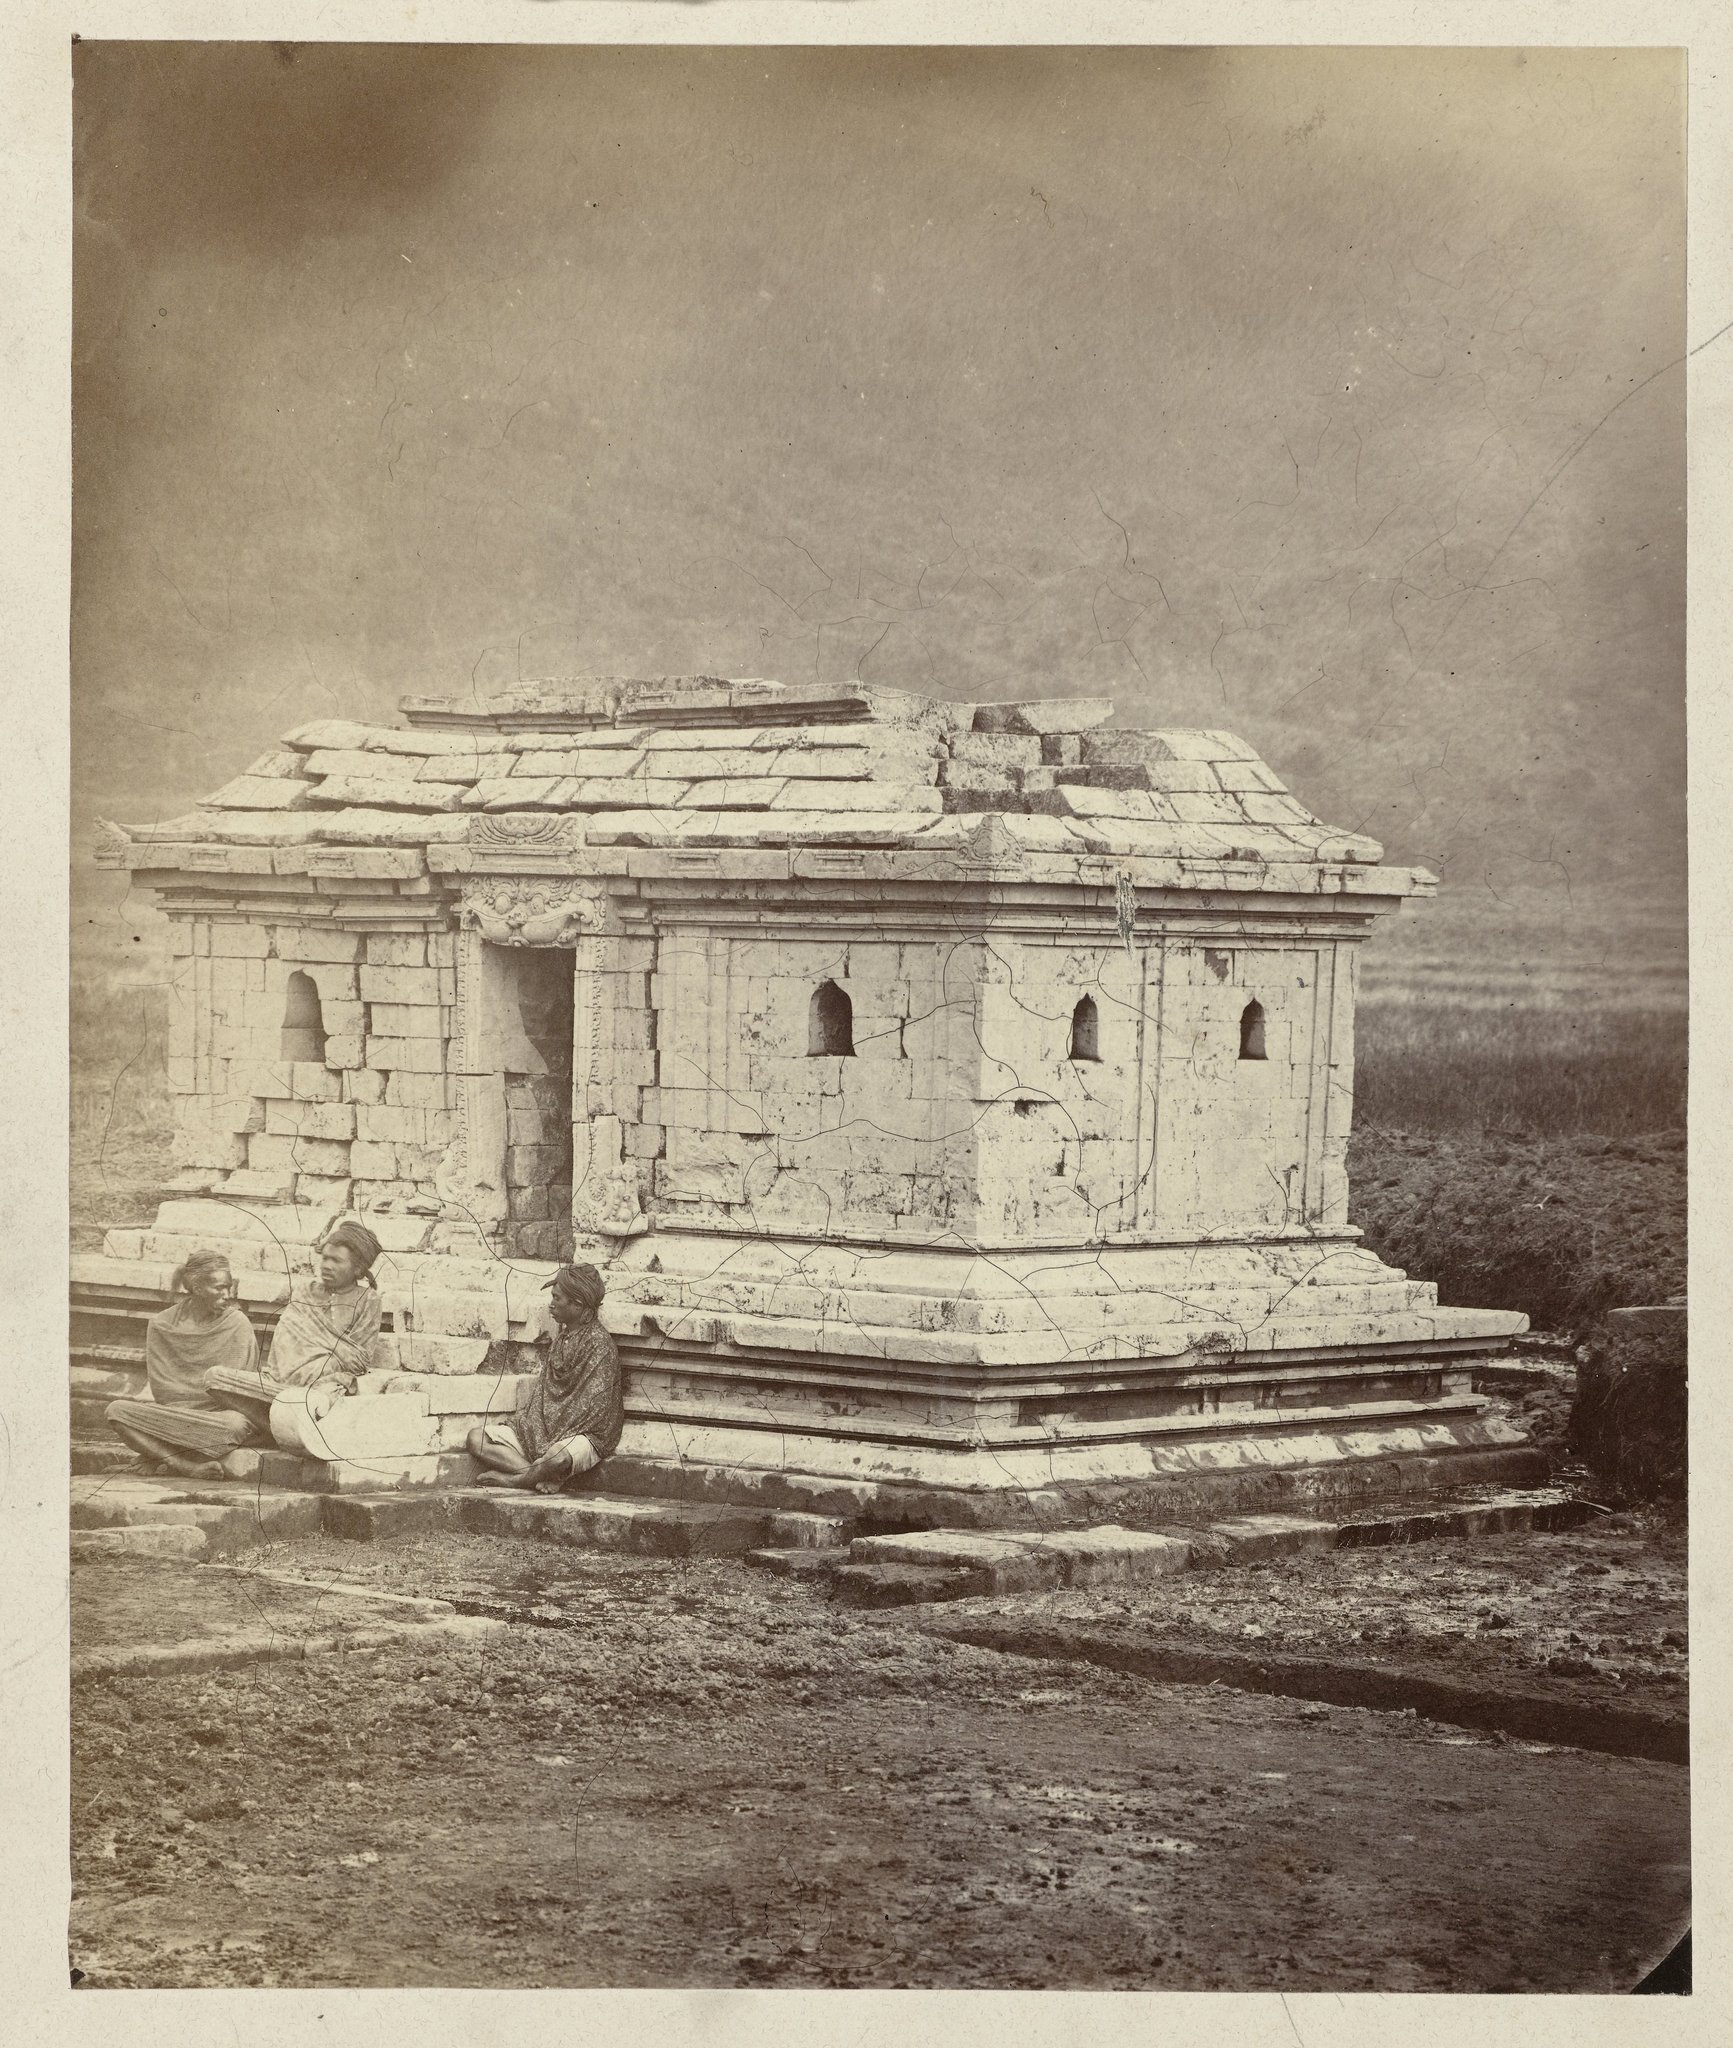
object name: photograph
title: Candi Semar, general view with some villagers sitting at the entrance (east).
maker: isidore kinsbergen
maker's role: fotograaf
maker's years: 1821-1905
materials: cardboard, paper, photographic support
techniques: albumen print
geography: java